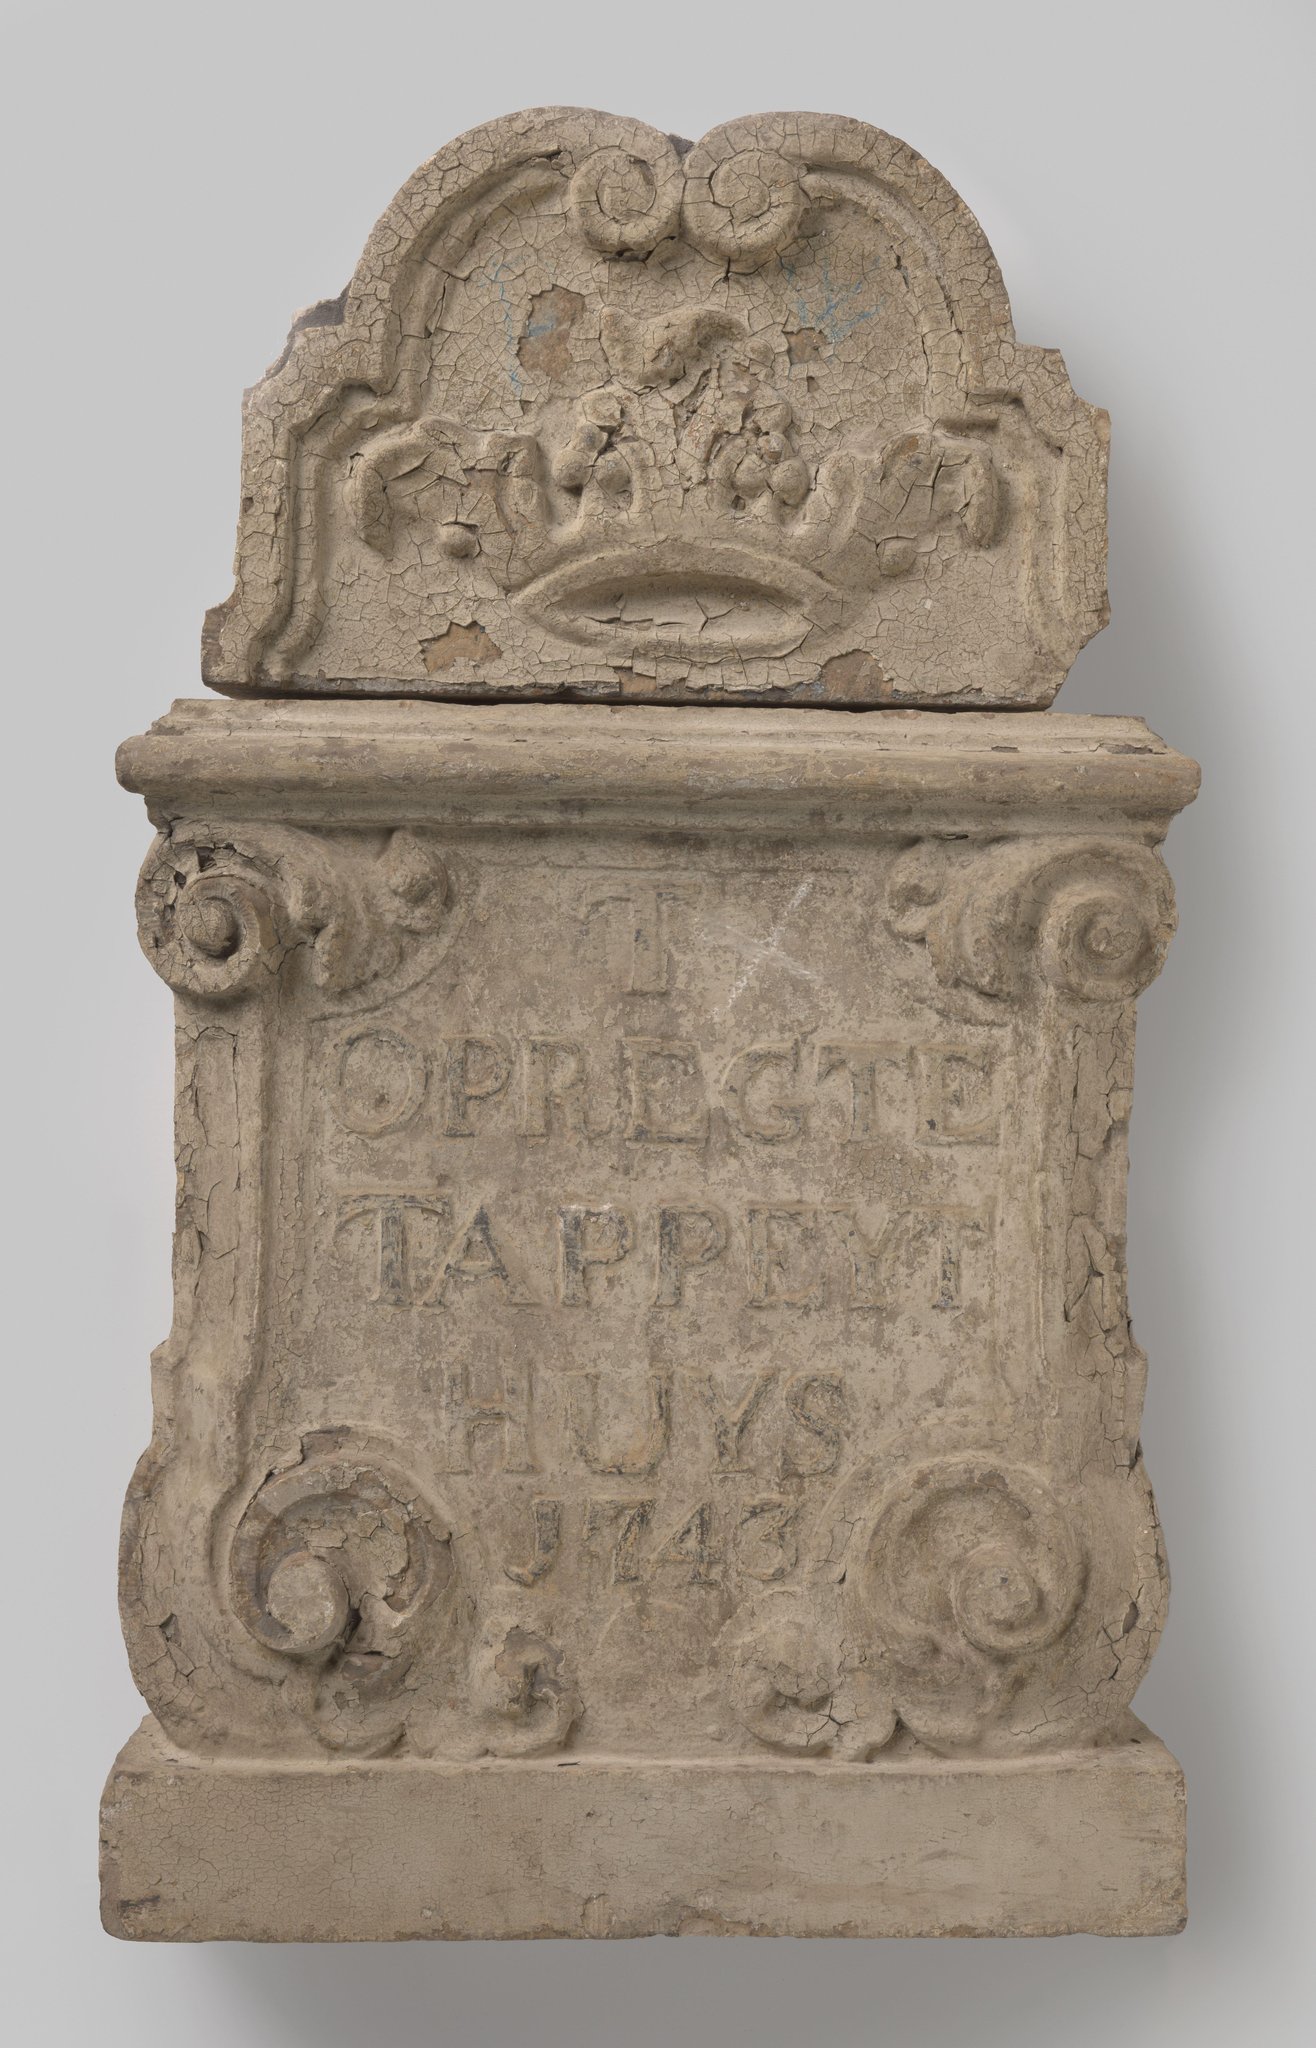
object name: gable stone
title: Gevelsteen met afbeelding en opschrift: T OPREGTE TAPPEYT HUYS 1743.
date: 1743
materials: stone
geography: netherlands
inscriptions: date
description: Staande rechthoek met zijkanten van voluten en acanthusbladeren, waarop het opschrift T OPREGTE TAPPEYT HUYS 1743. Bij de steen (KOG-ALS-165-1) hoort een steen in de vorm van een cartouche van voluten, waarbinnen een kroon (KOG-ALS-165-2). Verfresten.